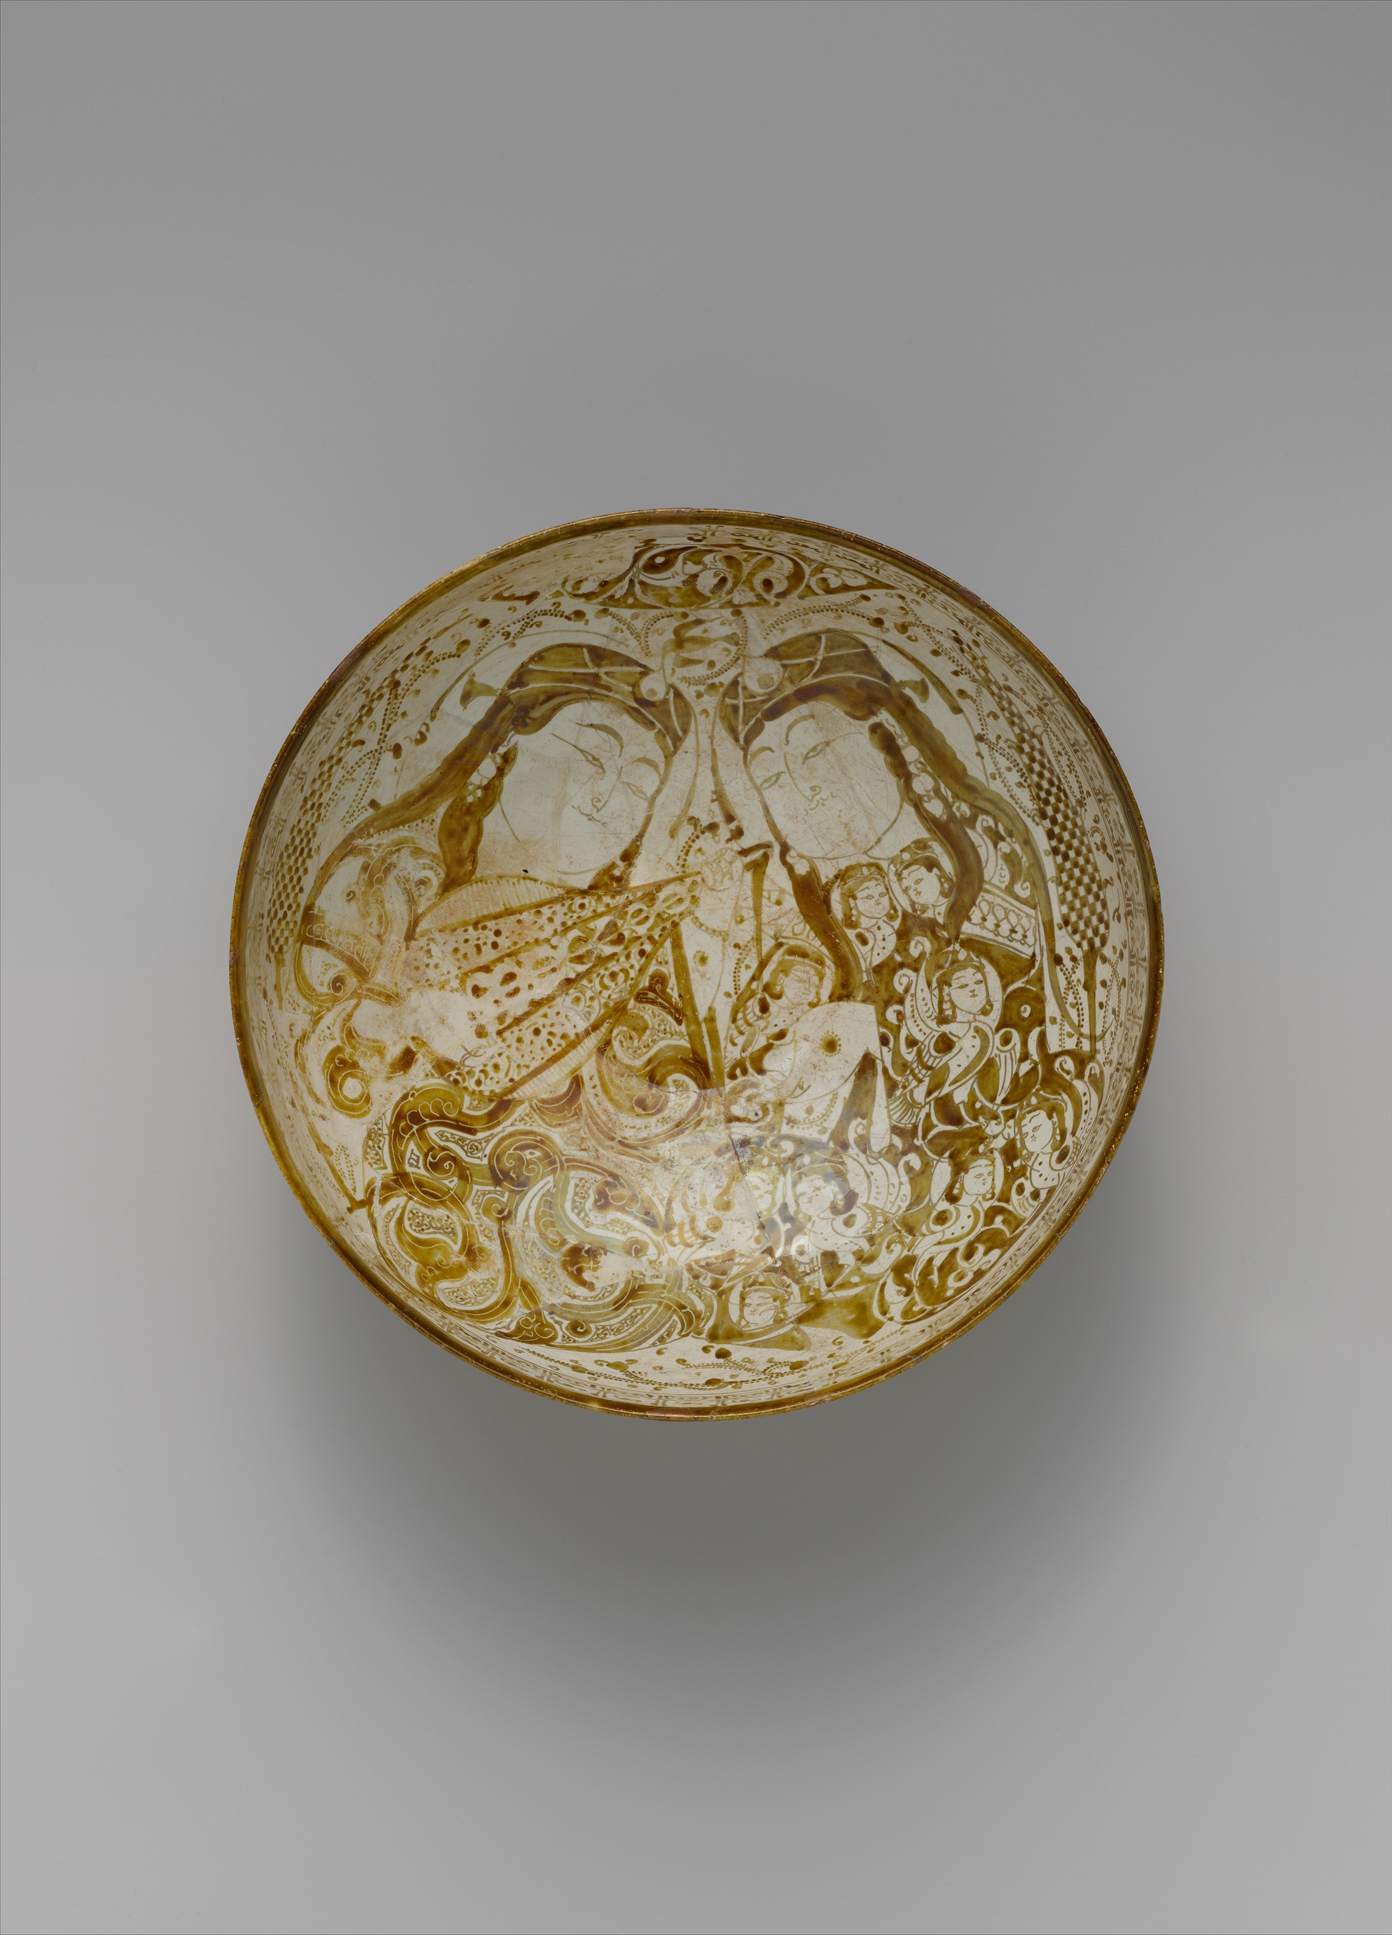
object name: bowl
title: Bowl With Musicians in a Garden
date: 1167-1233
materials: stonepaste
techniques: glazing, luster painting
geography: iran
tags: women,lutes